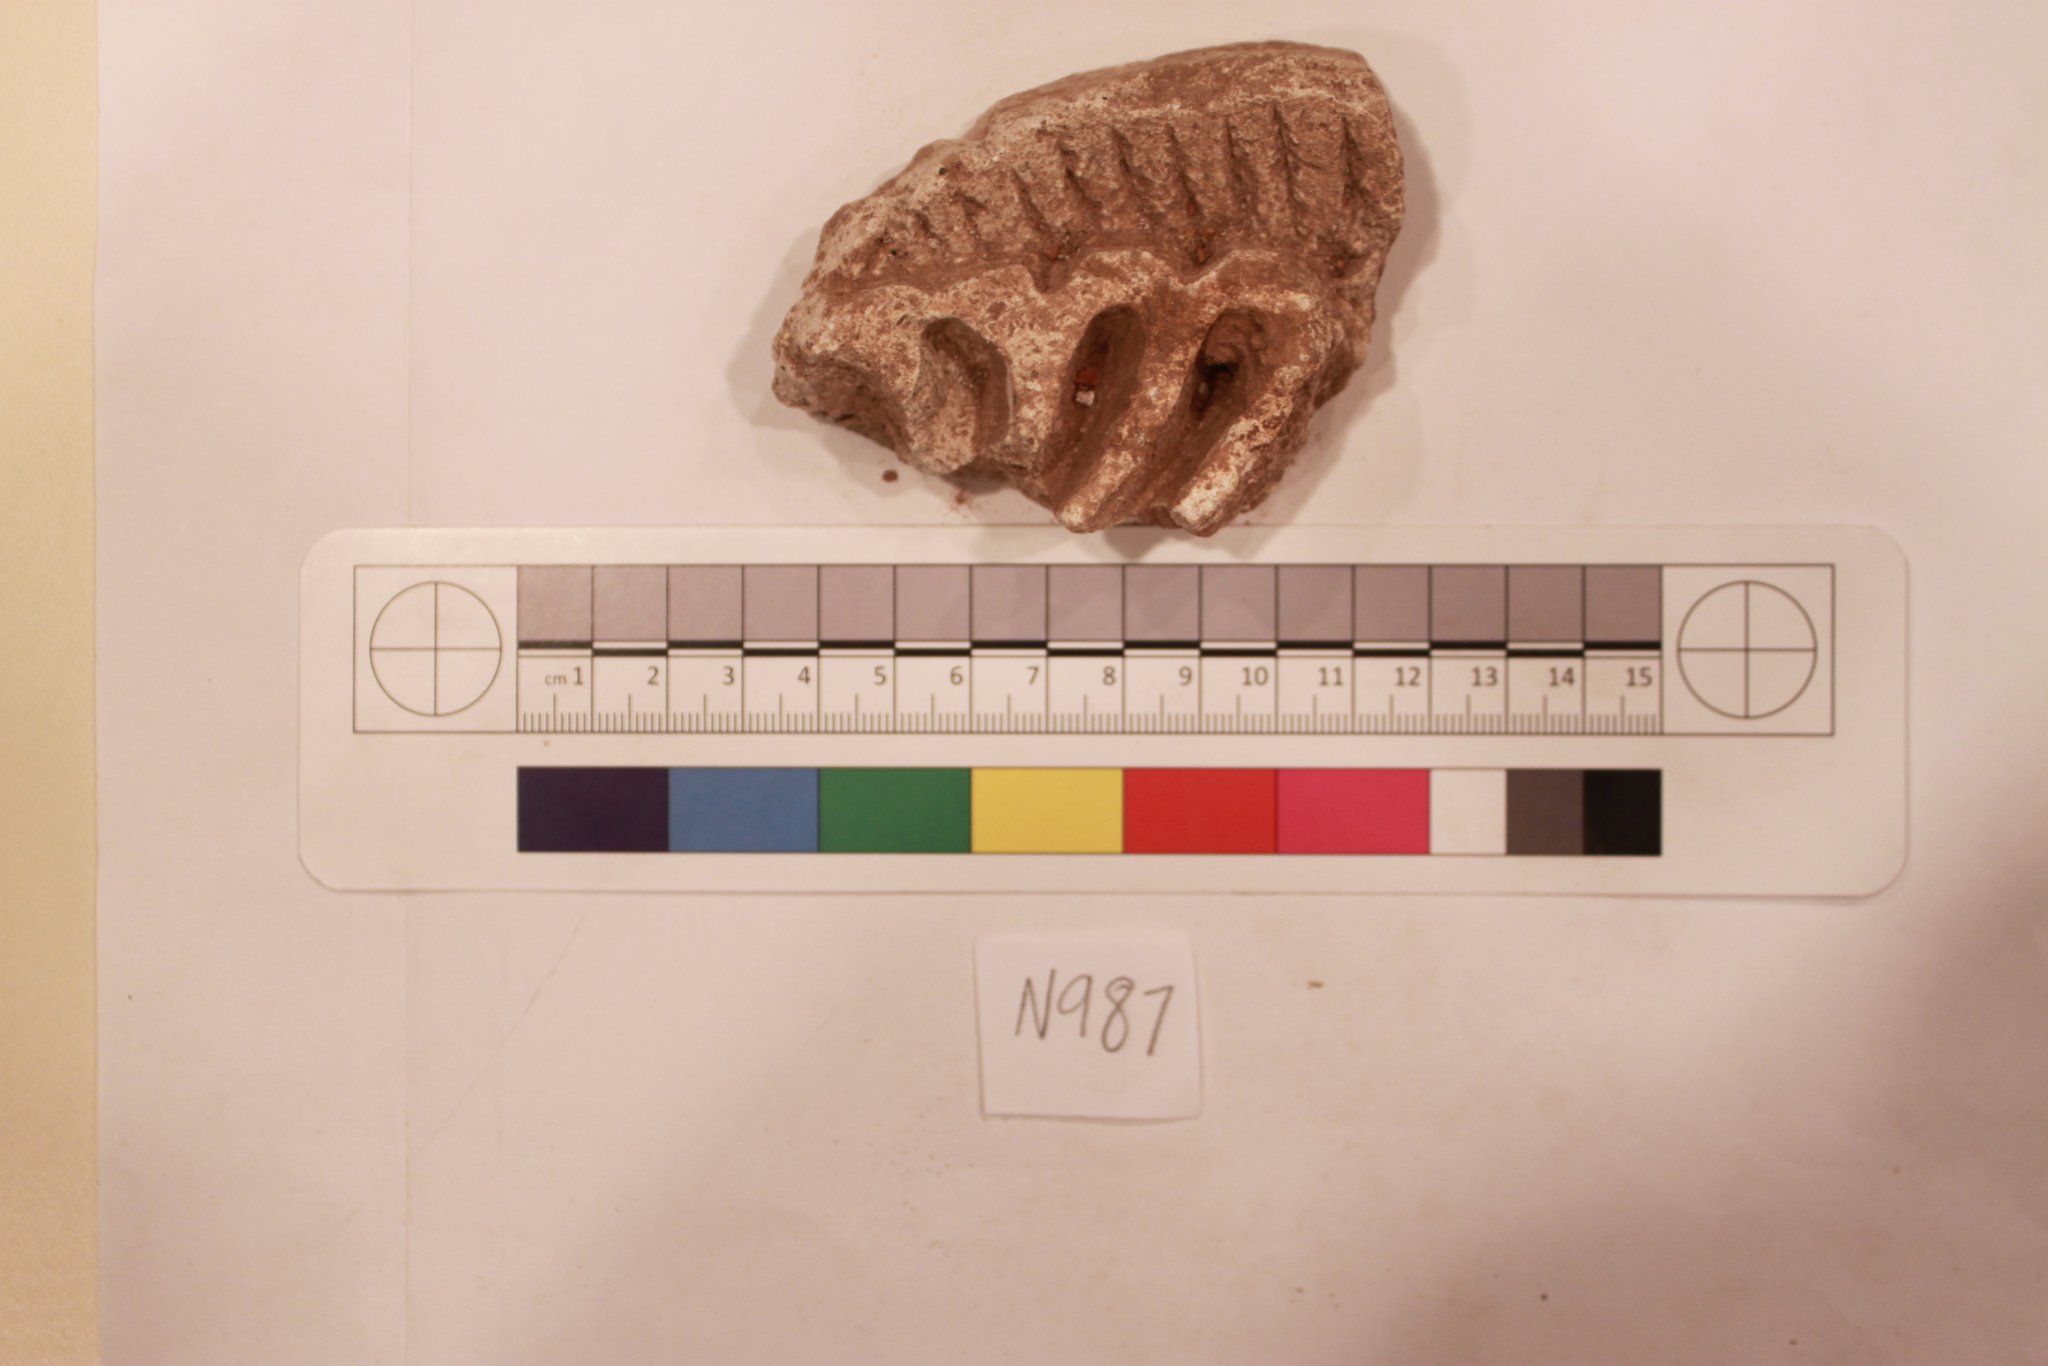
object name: fragment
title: Stucco Fragment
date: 701-1200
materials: plaster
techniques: carving, painting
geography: iran